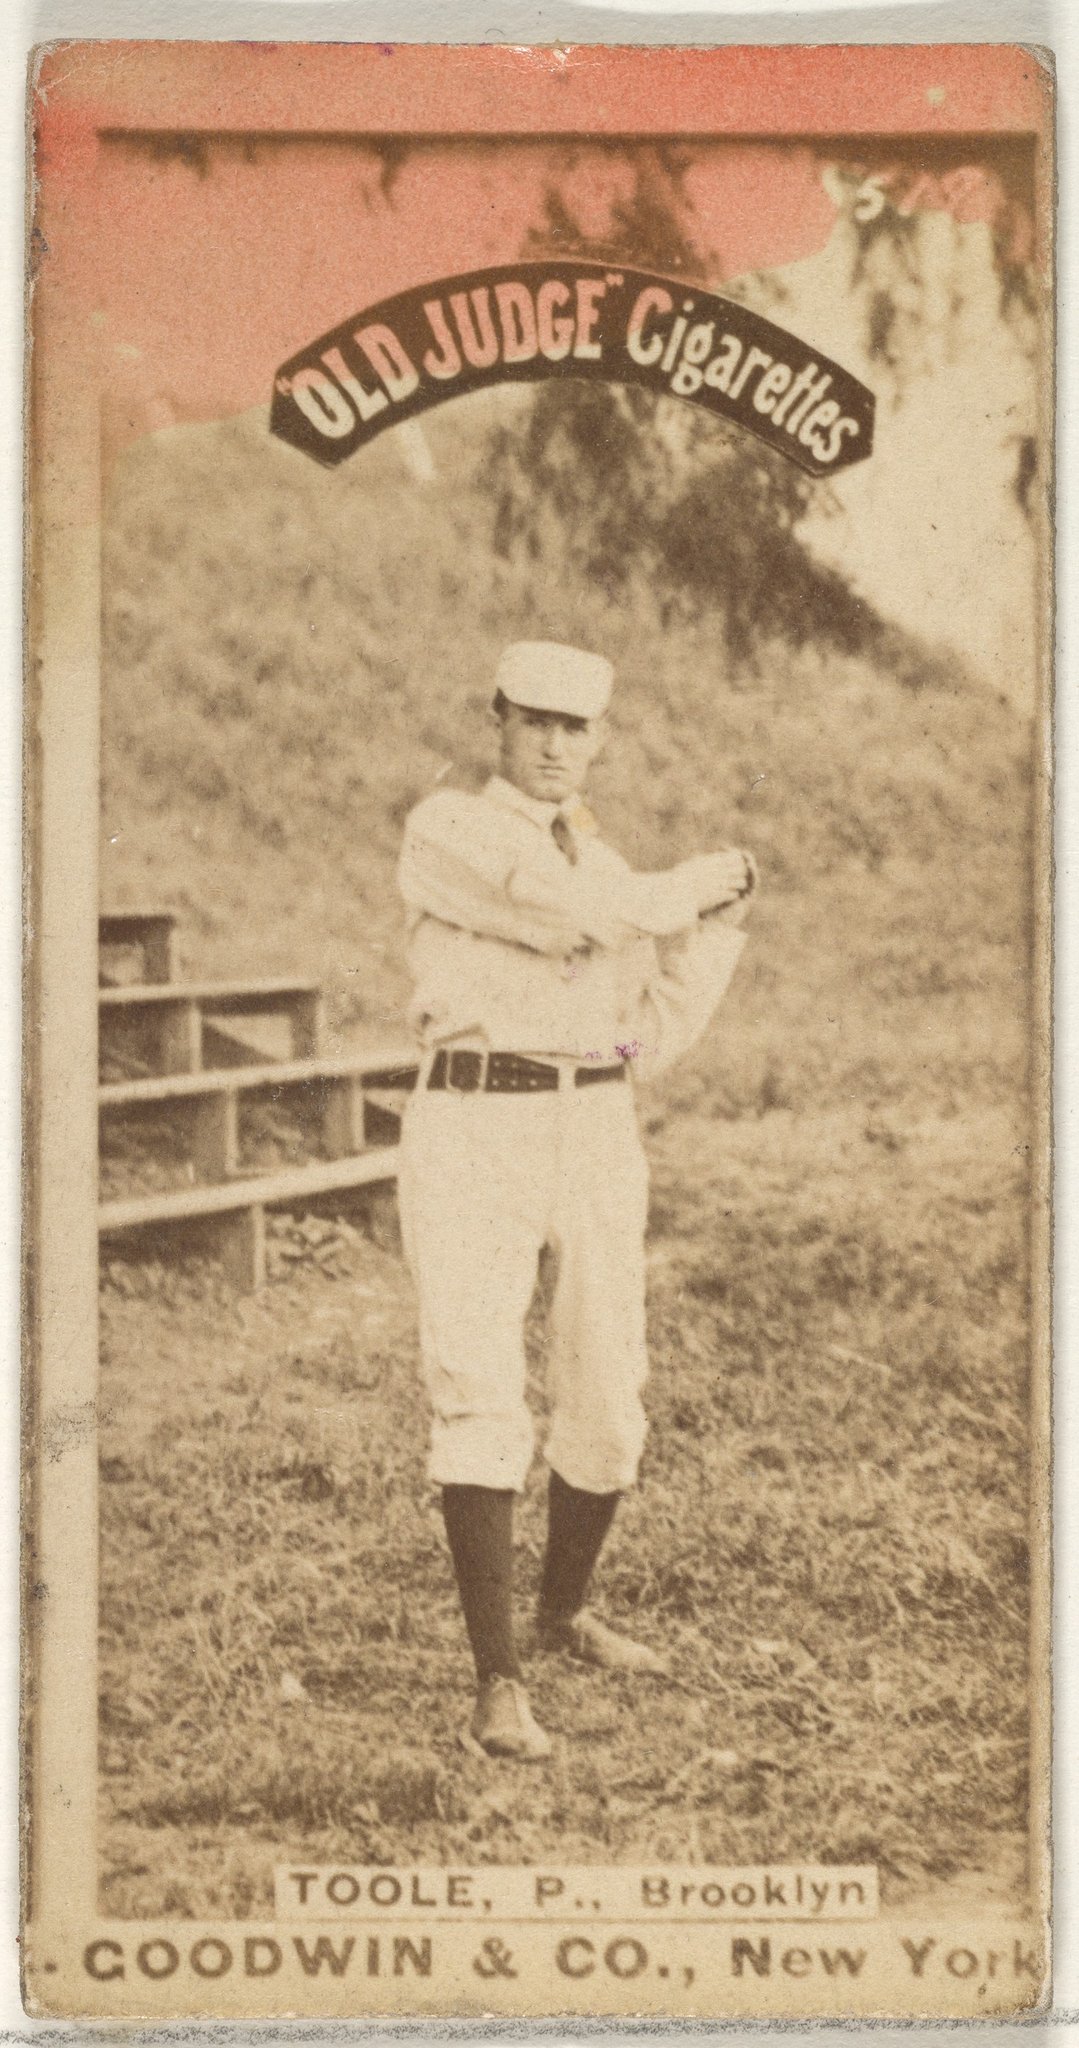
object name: baseball card, photograph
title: Toole, Pitcher, Brooklyn, from the Old Judge series (N172) for Old Judge Cigarettes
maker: goodwin & company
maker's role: publisher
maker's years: 1850-1950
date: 1887-1890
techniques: albumen silver print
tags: men,portraits,baseball,athletes